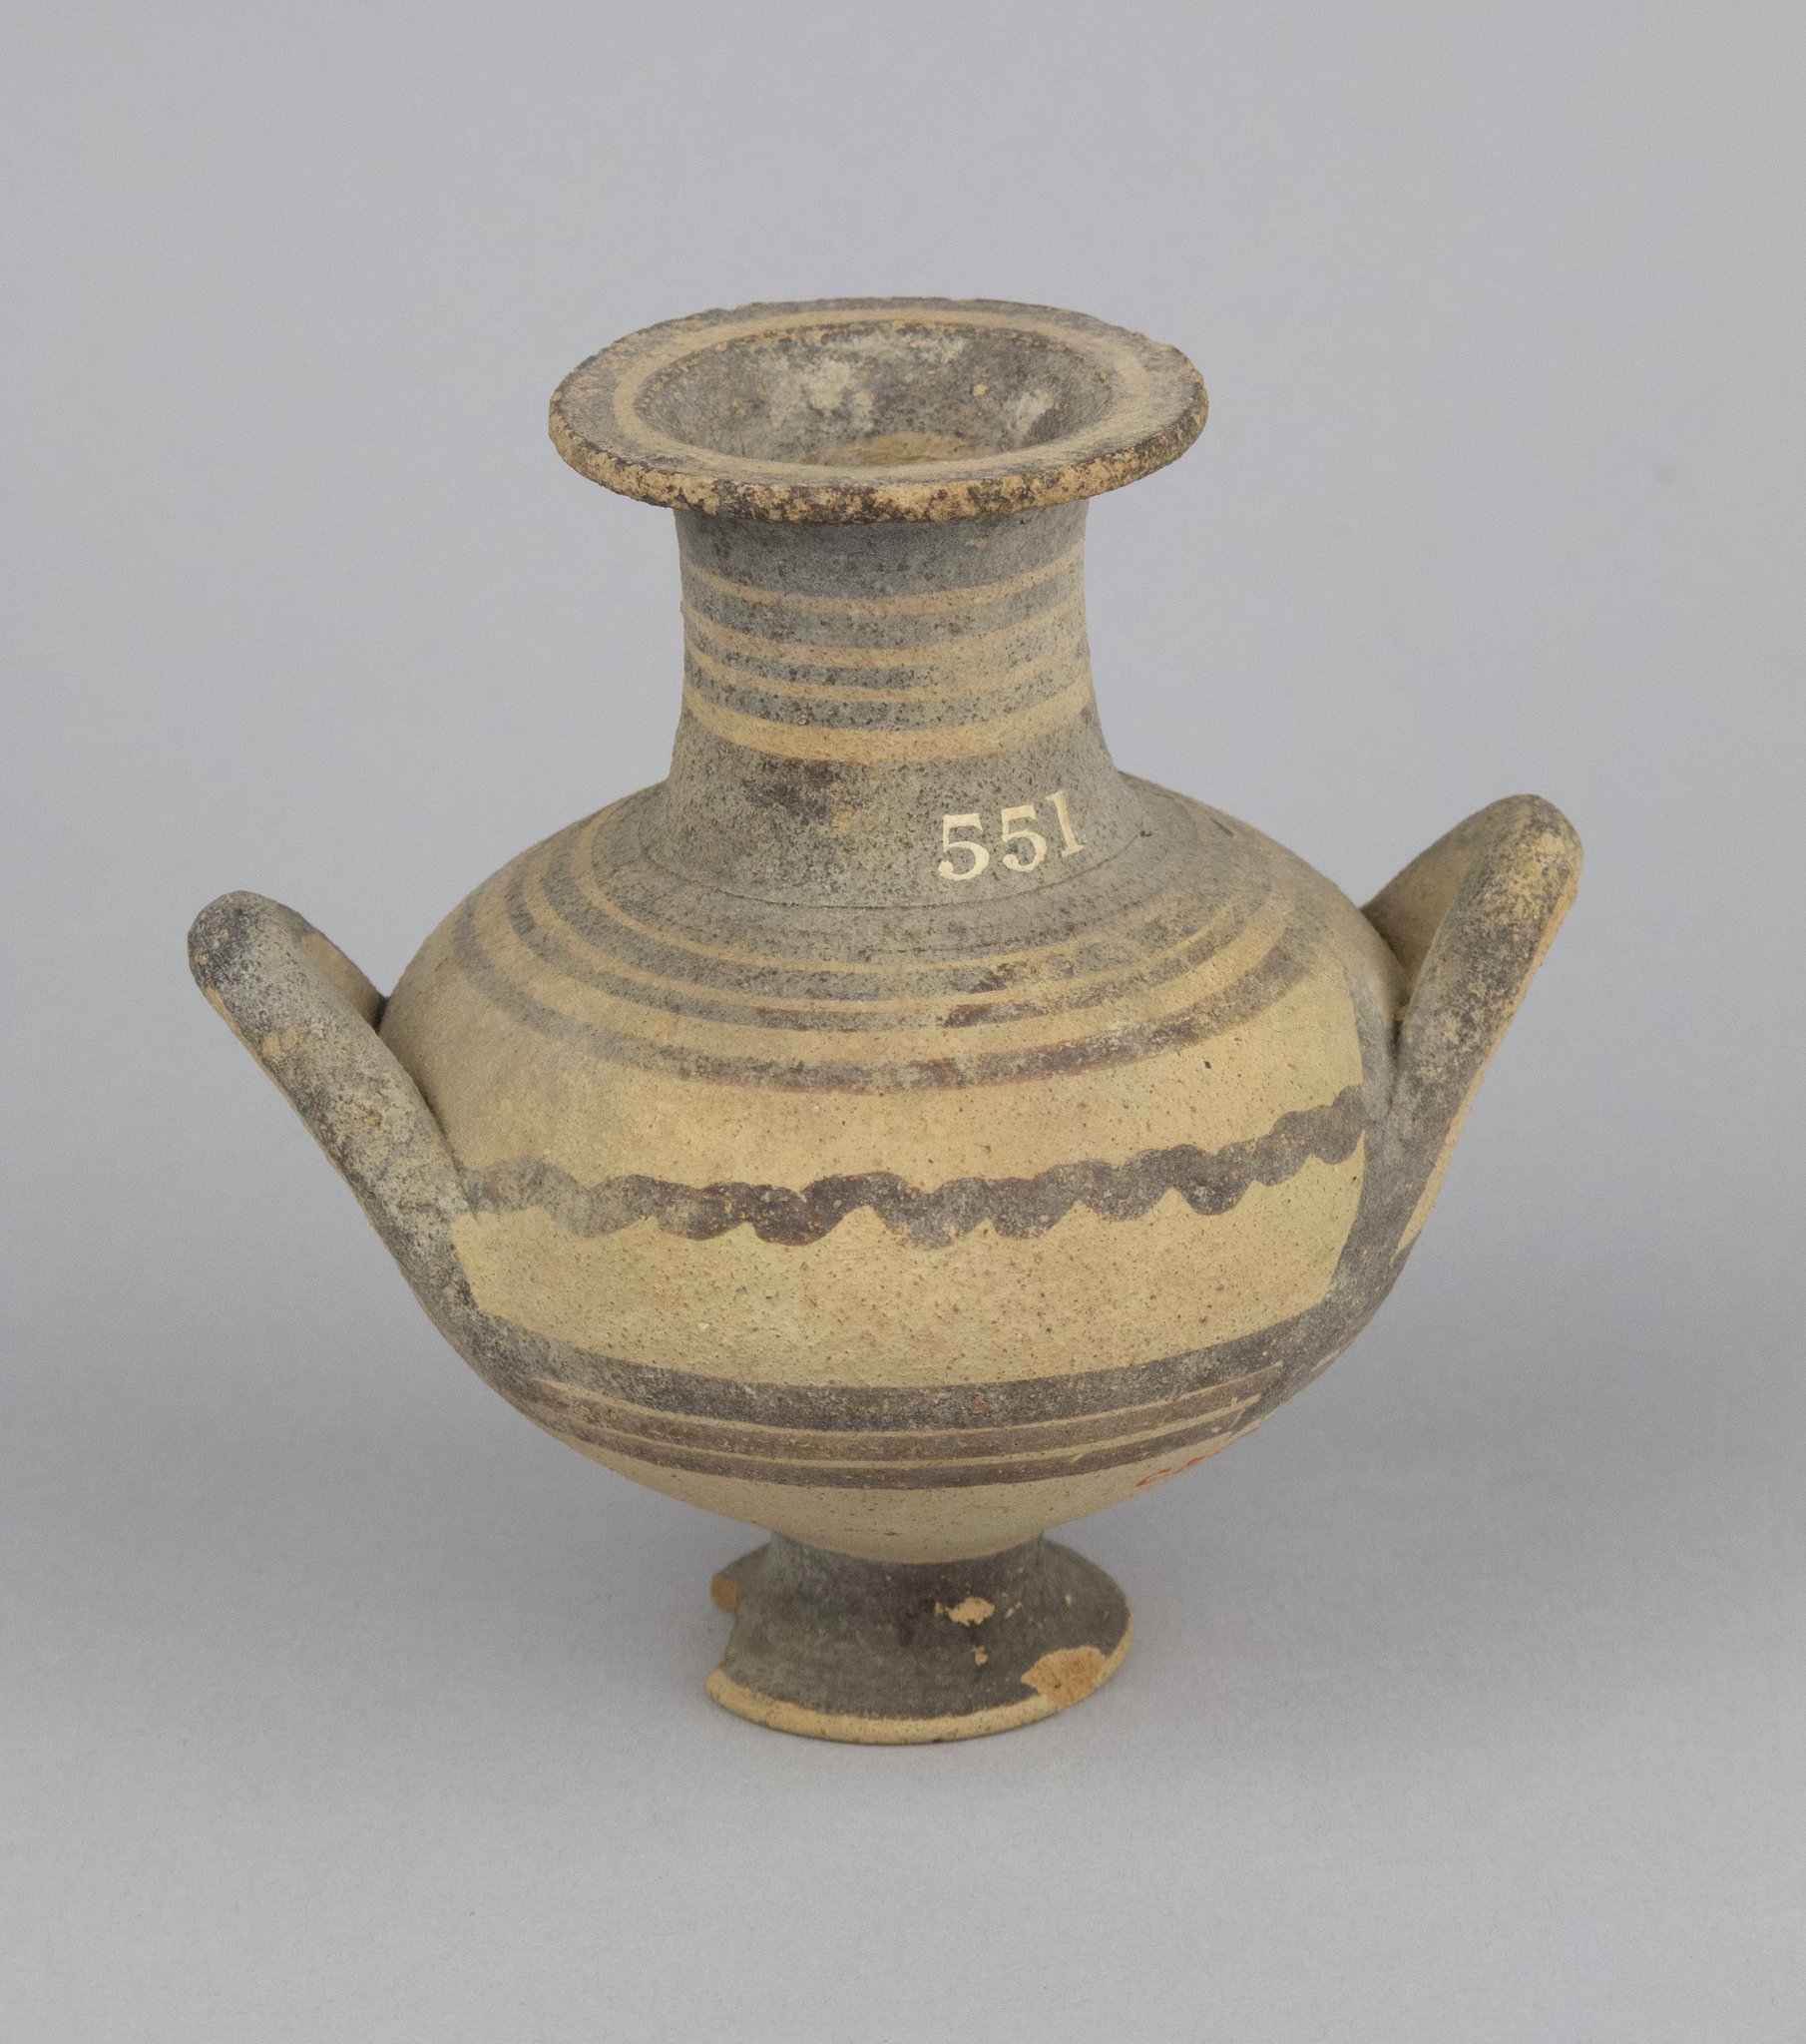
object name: juglet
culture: cypriot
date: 1050-950 BCE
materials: terracotta